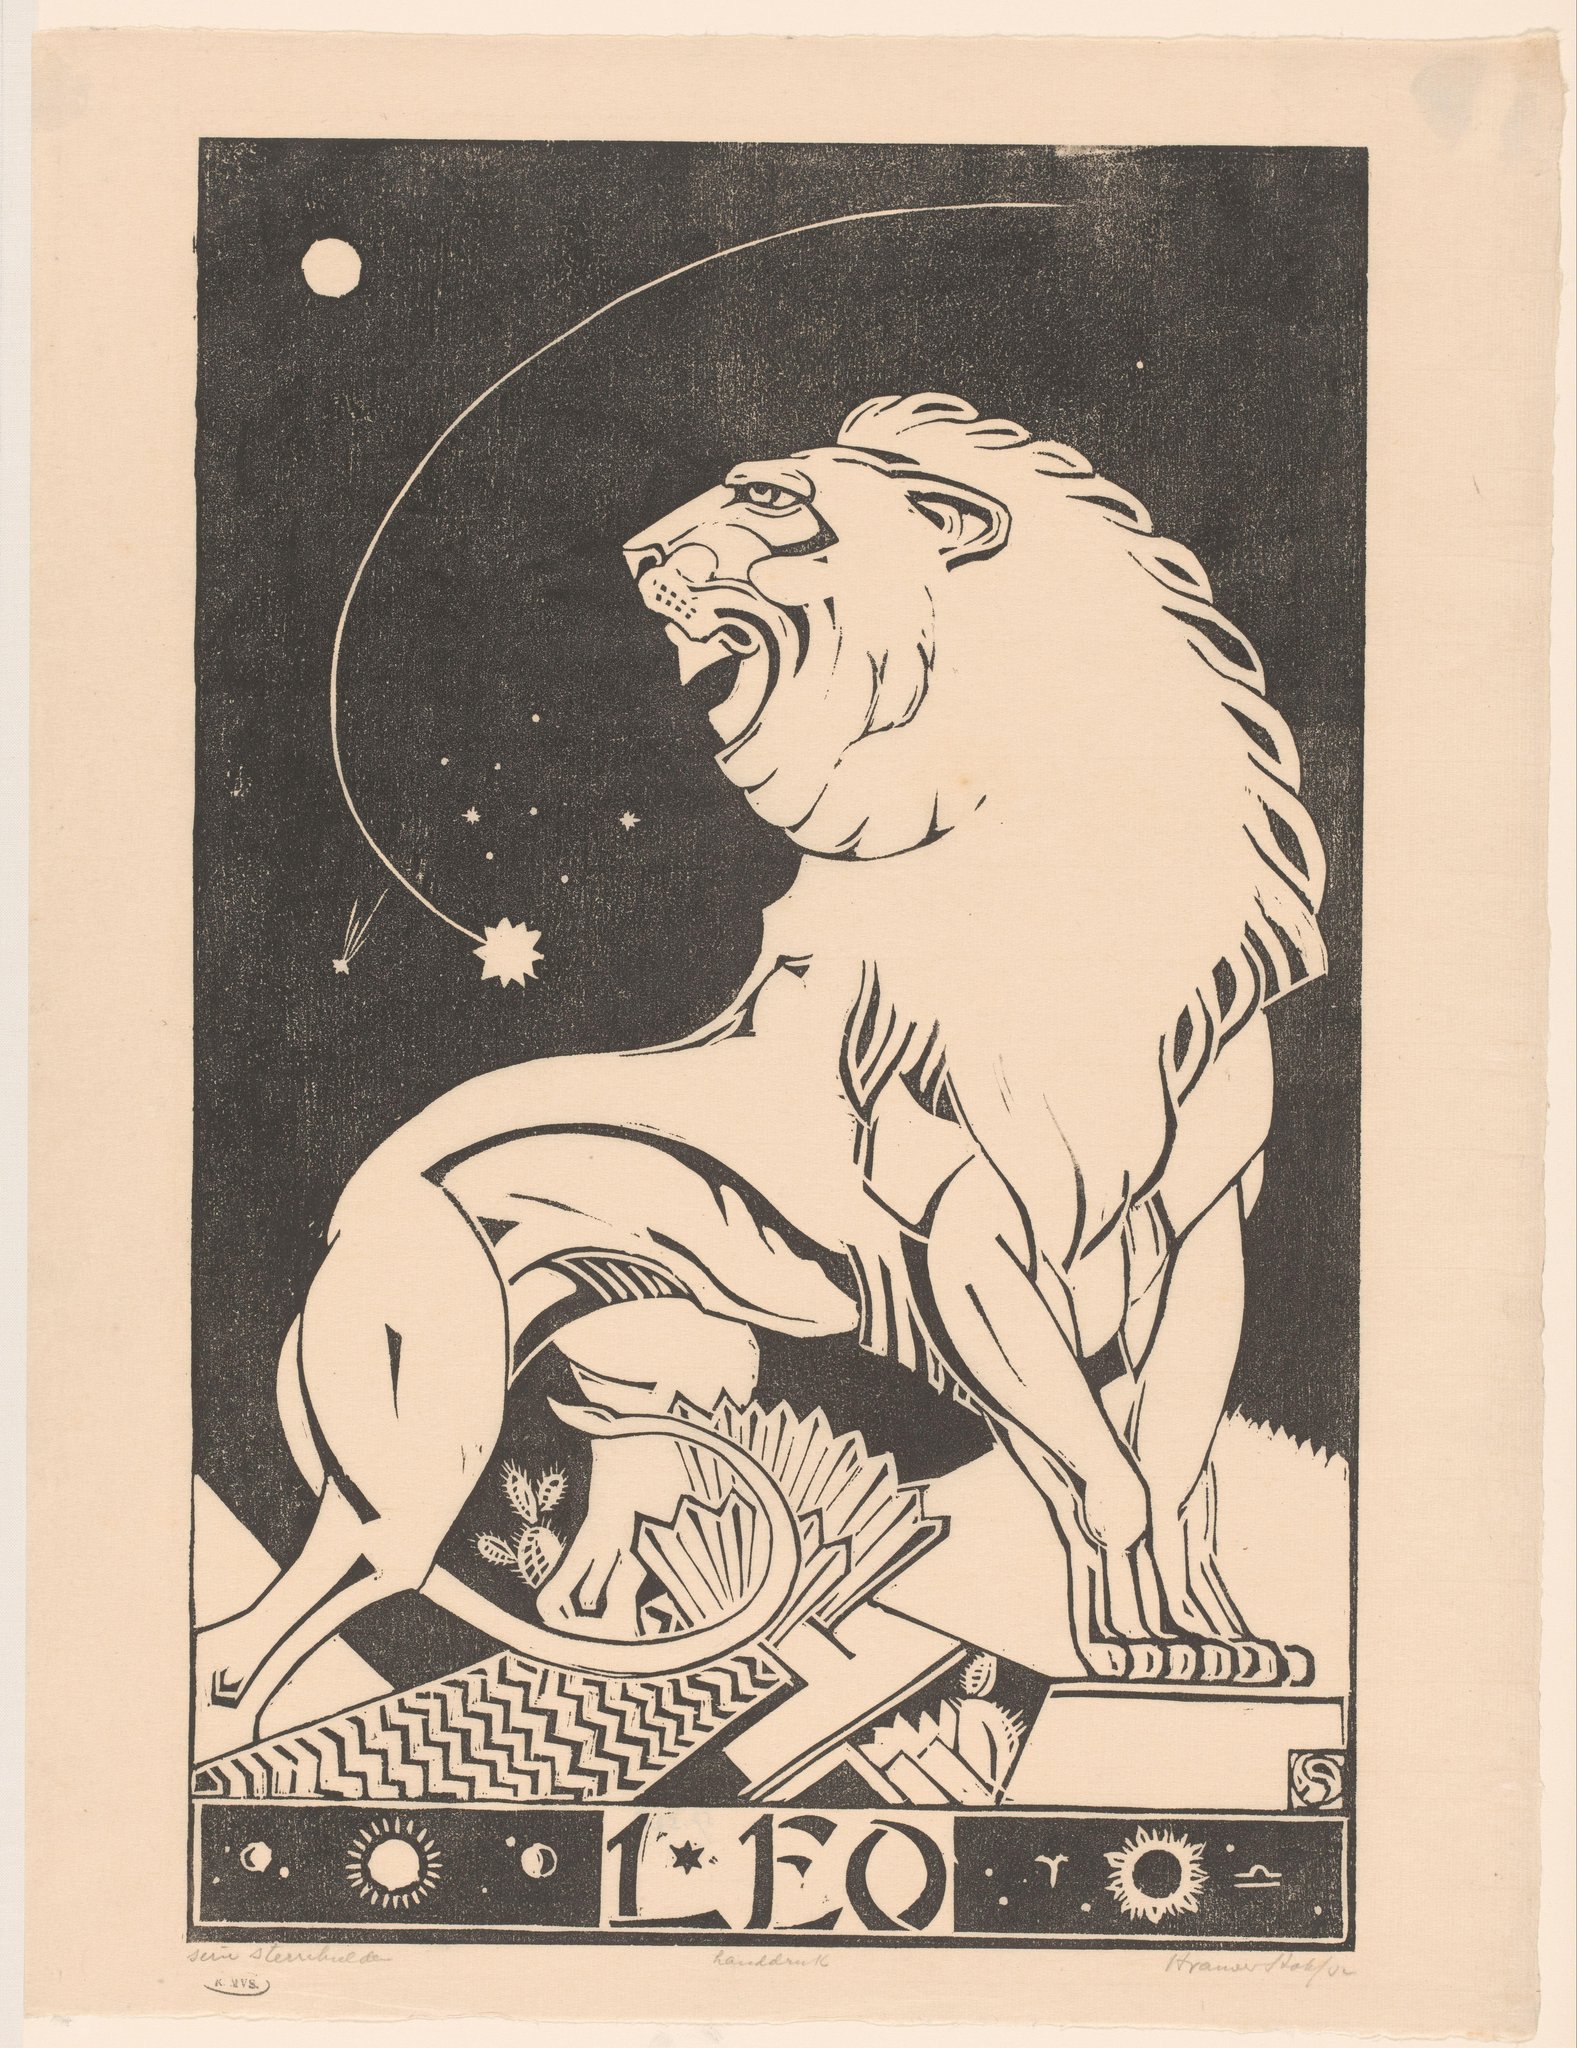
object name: print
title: Sterrenbeeld leeuw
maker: henri van der stok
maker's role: print maker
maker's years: 1870-1946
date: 1880-1946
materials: paper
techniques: woodcut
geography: netherlands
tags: leo (zodiacal sign of july)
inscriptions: inscription: ‘serie sterrebeelden’, collector's mark: Lugt 2228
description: Een opkijkende leeuw voor de sterrenhemel.